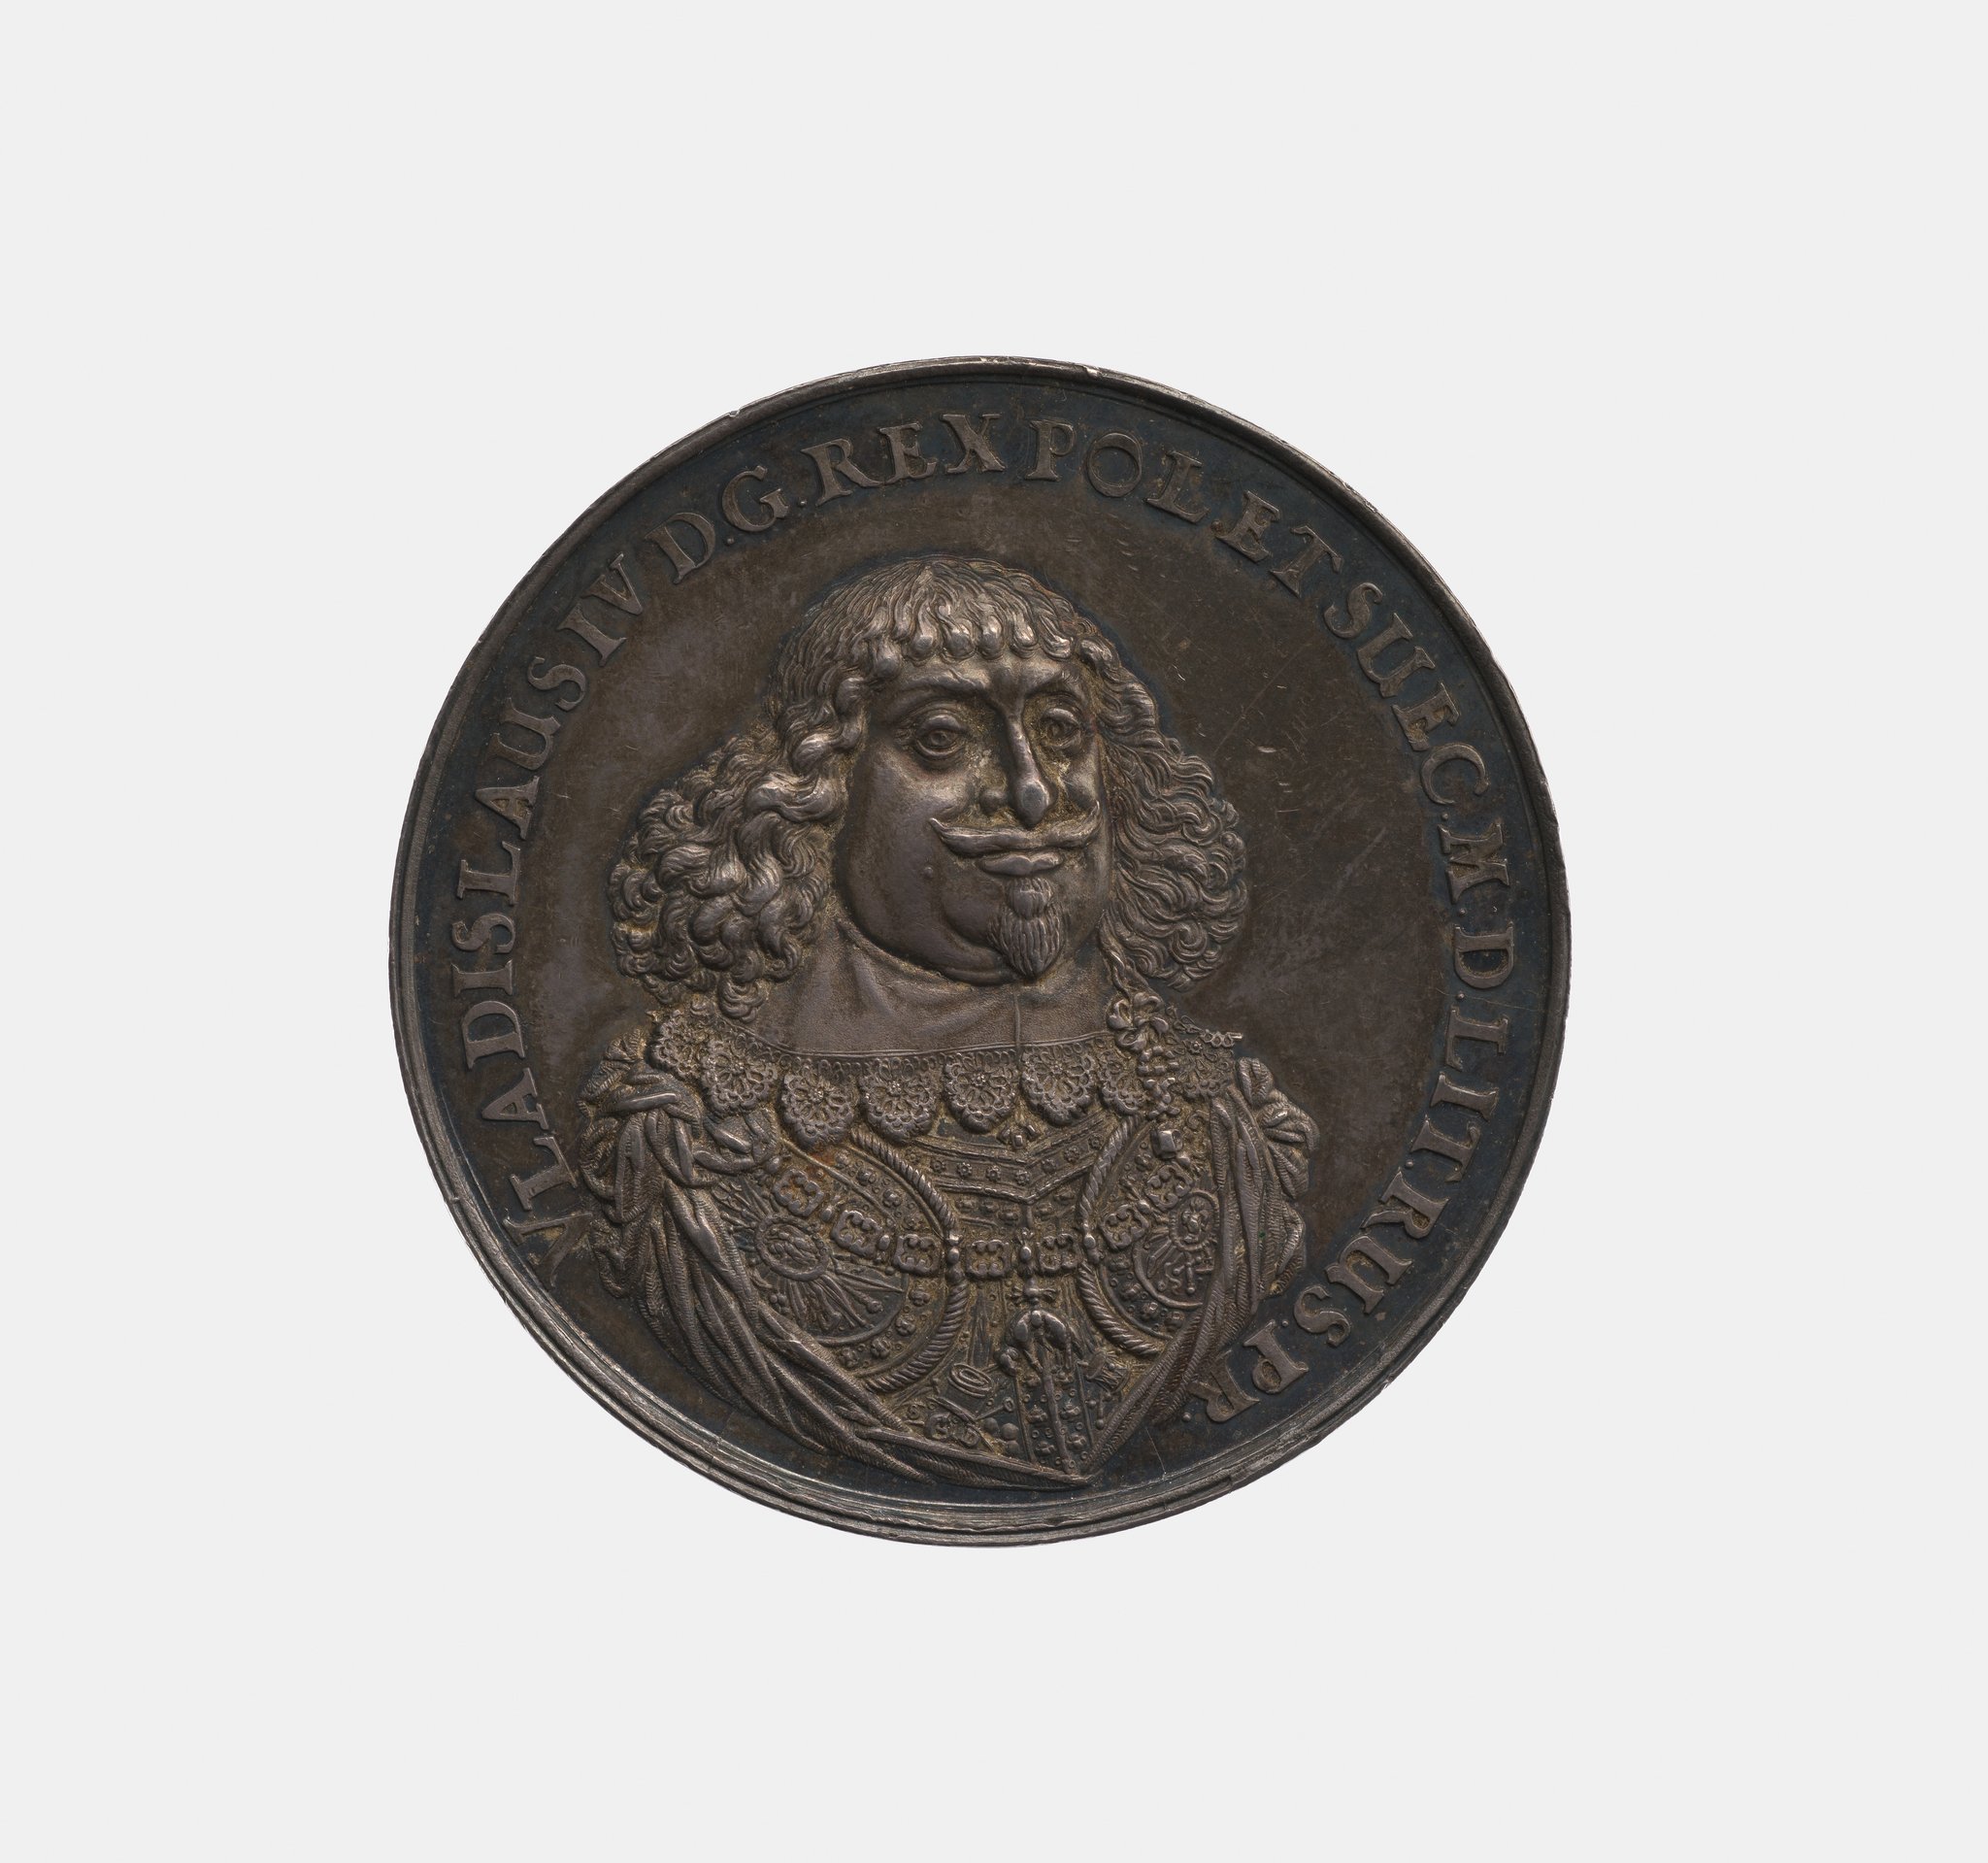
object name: medal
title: Commemorative medal on the marriage of Wladislaus IV (Władysław IV Vasa), King of Poland and Ludovica (Marie Louise) Gonzaga, Princess of Mantua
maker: sebastian dadler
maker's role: artist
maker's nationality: german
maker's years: 1586-1657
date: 1646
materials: silver